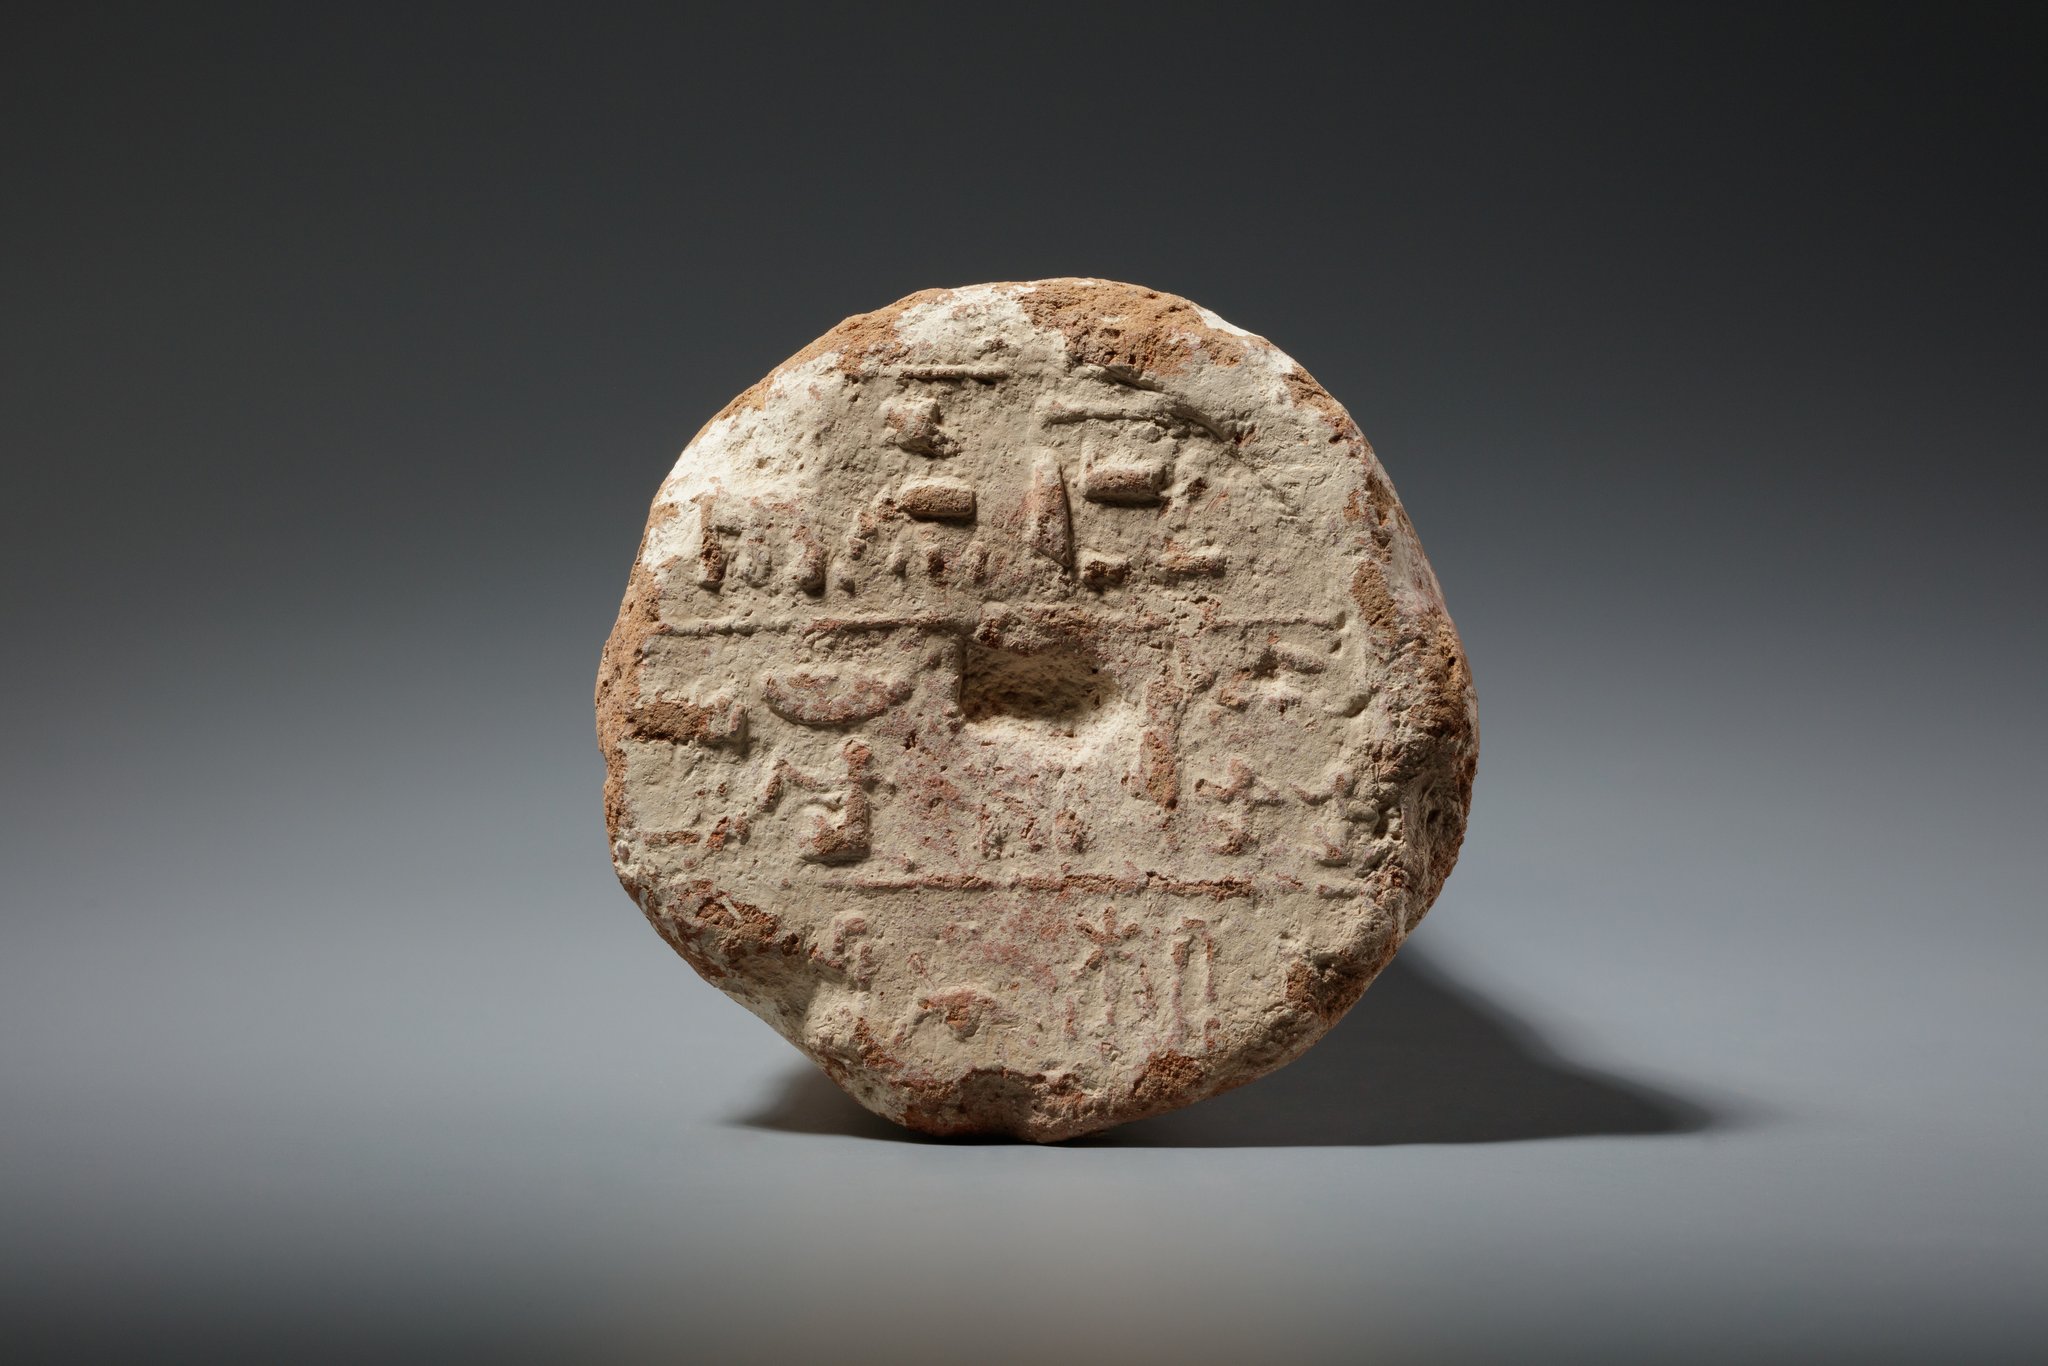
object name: cone, davy 558, nebamun, tt 179, amun, scribe, intef, ahmose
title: Funerary Cone of the Scribe Nebamun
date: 1479-1458 BCE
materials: pottery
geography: egypt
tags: hieroglyphs